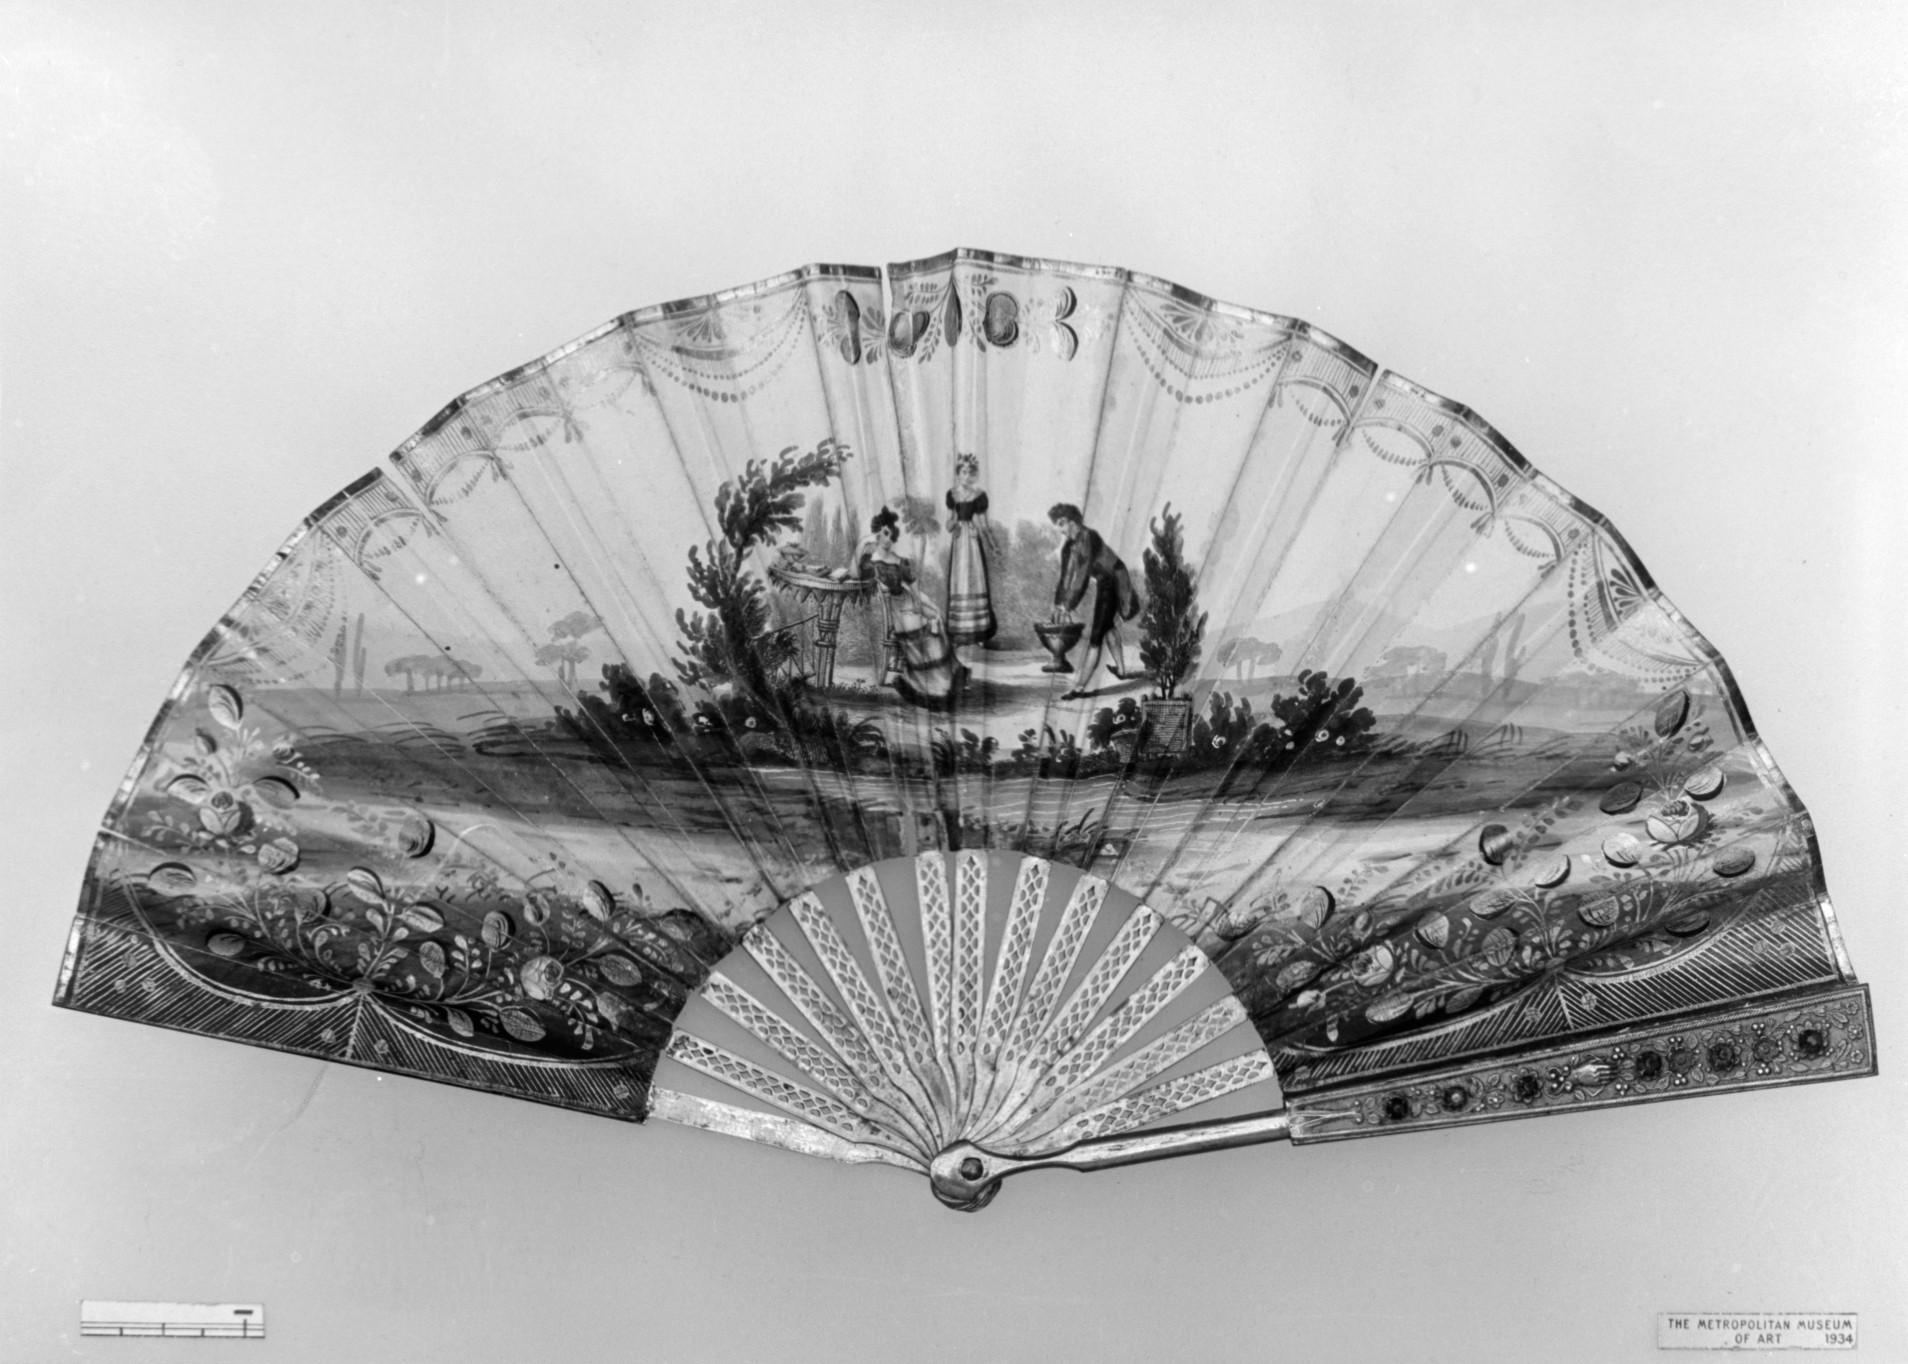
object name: fan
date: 1820-1835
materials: gilt bronze, glass, paper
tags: men,women,landscapes